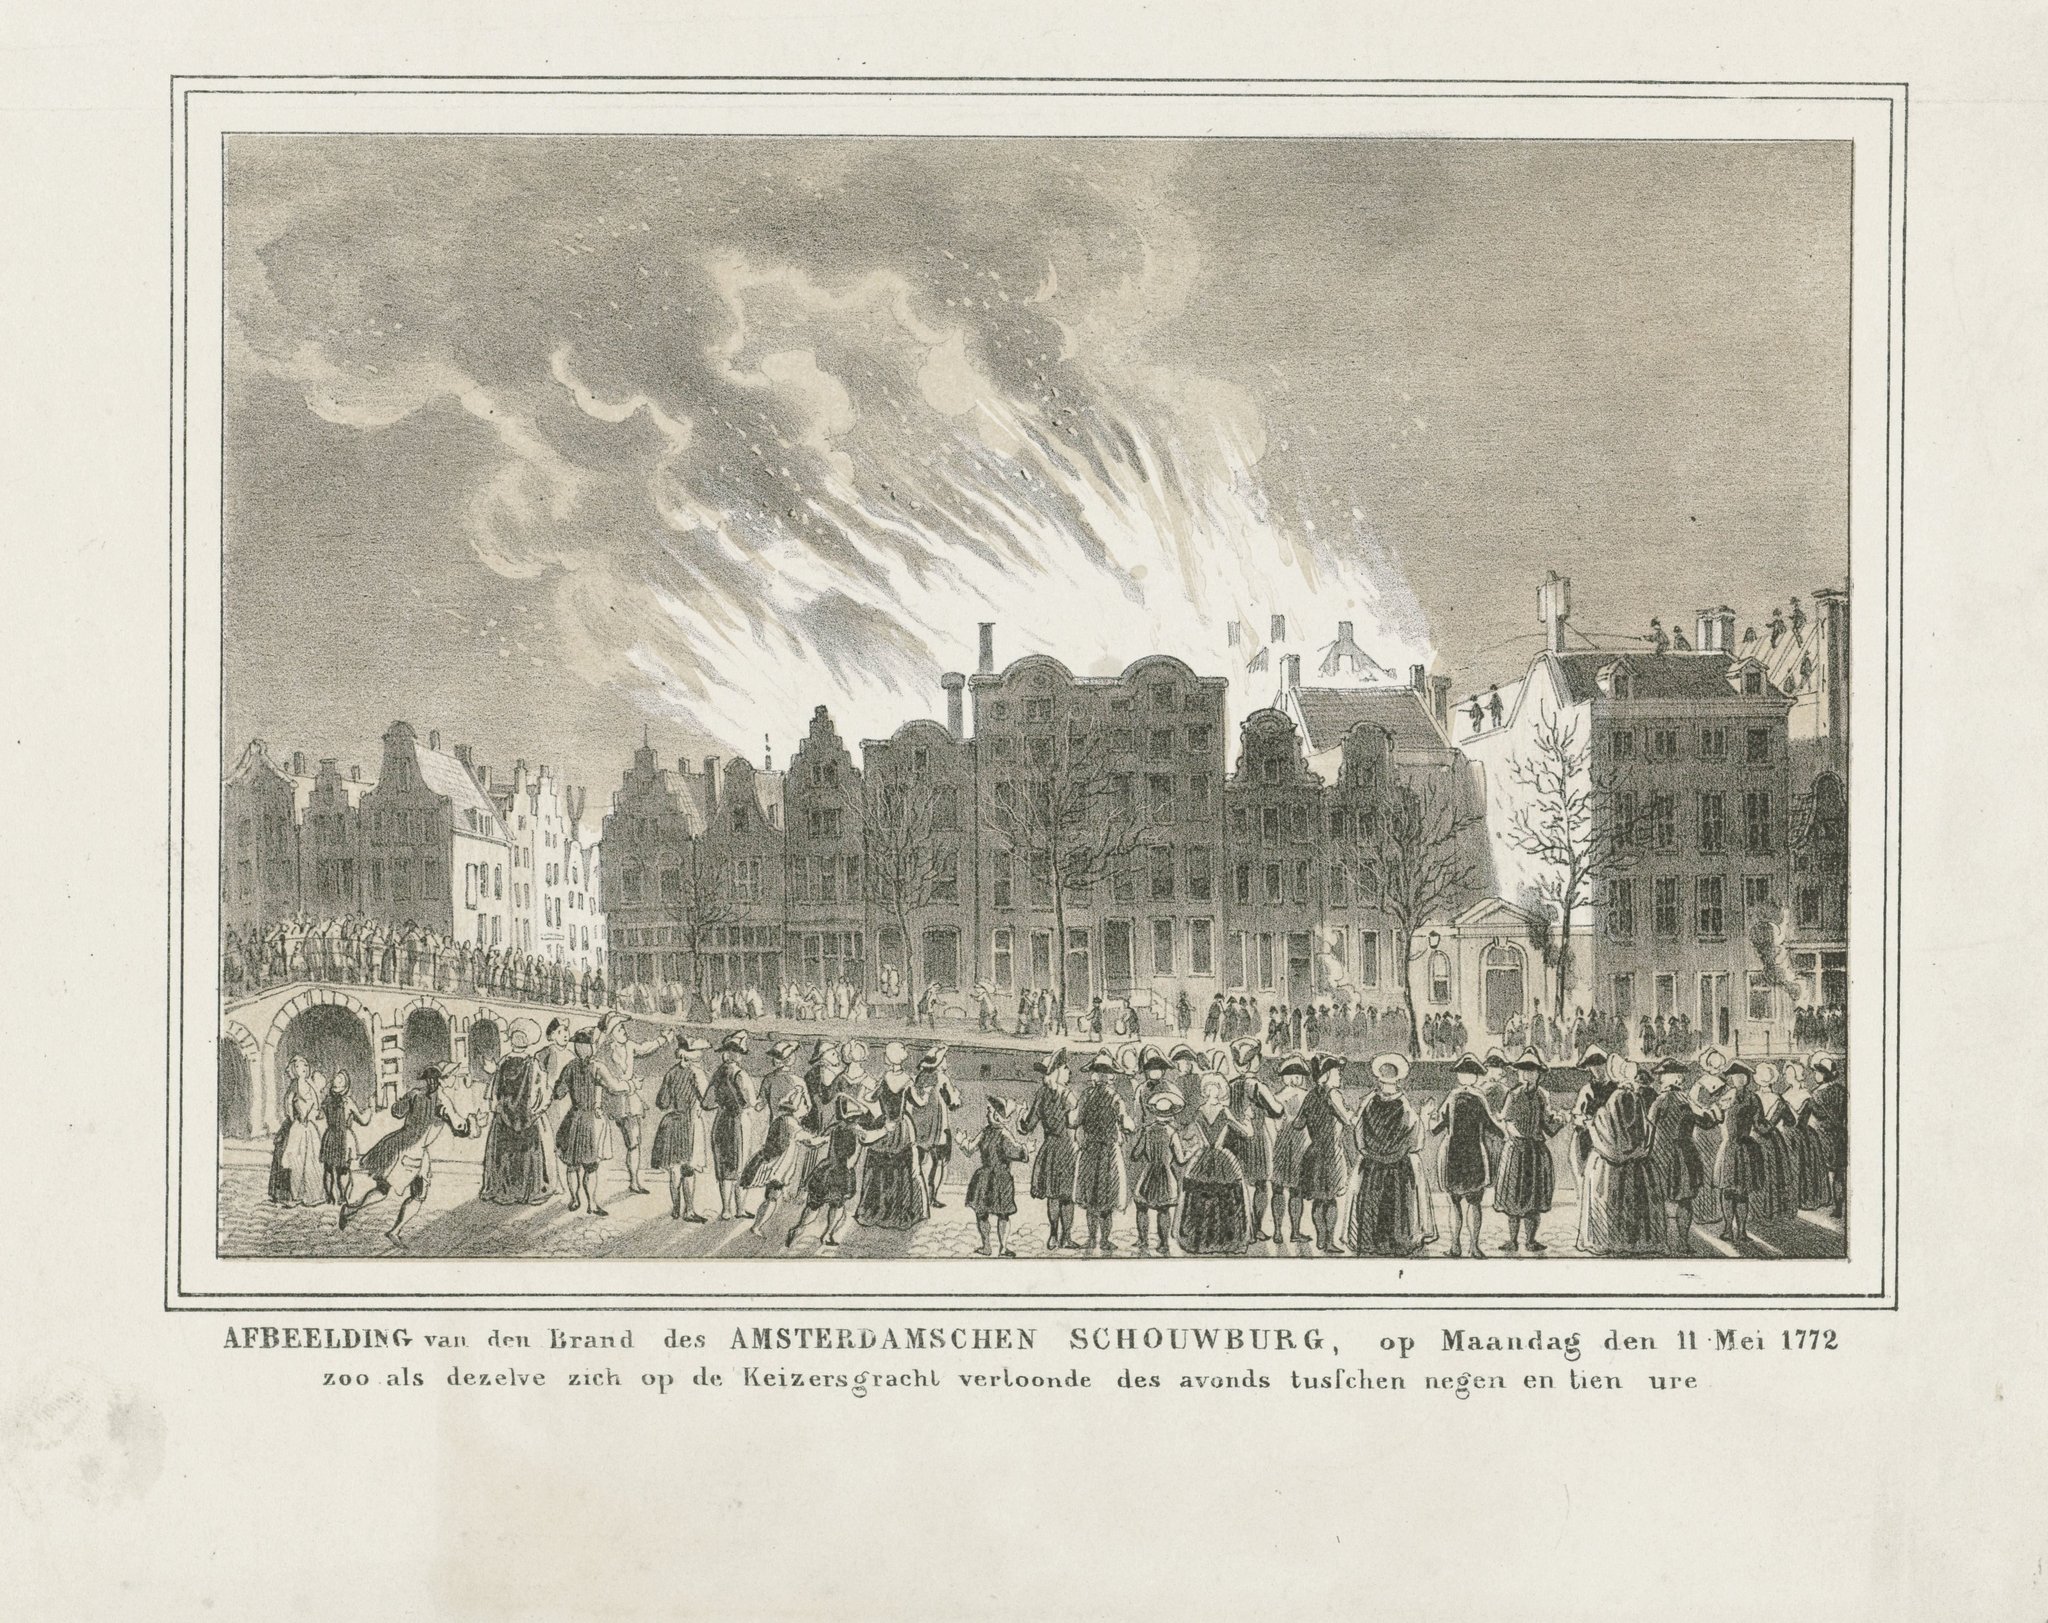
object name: print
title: Afbeelding van den Brand des Amsterdamschen Schouwburg, op Maandag den 11 Mei 1772 zoo als dezelve zich op de Keizersgracht vertoonde des avonds tusschen negen en tien ure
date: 1820-1860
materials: paper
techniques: tone lithography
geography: northern netherlands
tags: on fire, ablaze, theatre, theatrical performance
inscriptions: collector's mark: Lugt 2228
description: De uitslaande brand in de Amsterdamse Schouwburg gezien vanaf de Keizersgracht. Op de kades en brug staat het toegestroomde publiek.